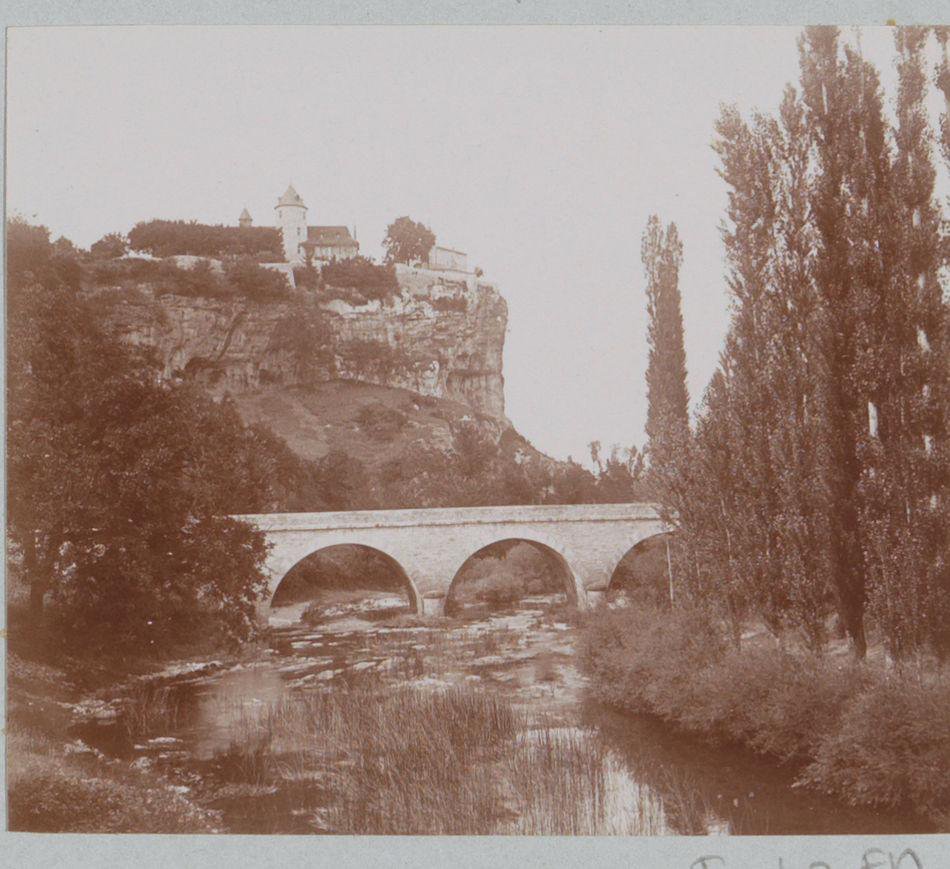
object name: photograph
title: Gezicht op een stad op rotsen in Frankrijk, met op de voorgrond een brug over een rivier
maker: Anonymous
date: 1905-1910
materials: paper, photographic support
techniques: gelatin silver print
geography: france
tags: landscape with bridge, viaduct or aqueduct, prospect of city, town panorama, silhouette of city, france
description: Onderdeel van Fotoalbum van een Franse amateurfotograaf met bezienswaardigheden in Frankrijk, Zwitserland en Italië.